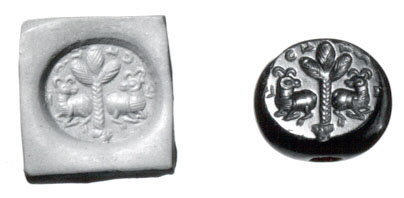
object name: stamp seal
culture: sasanian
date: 401-500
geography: iran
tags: animals,trees